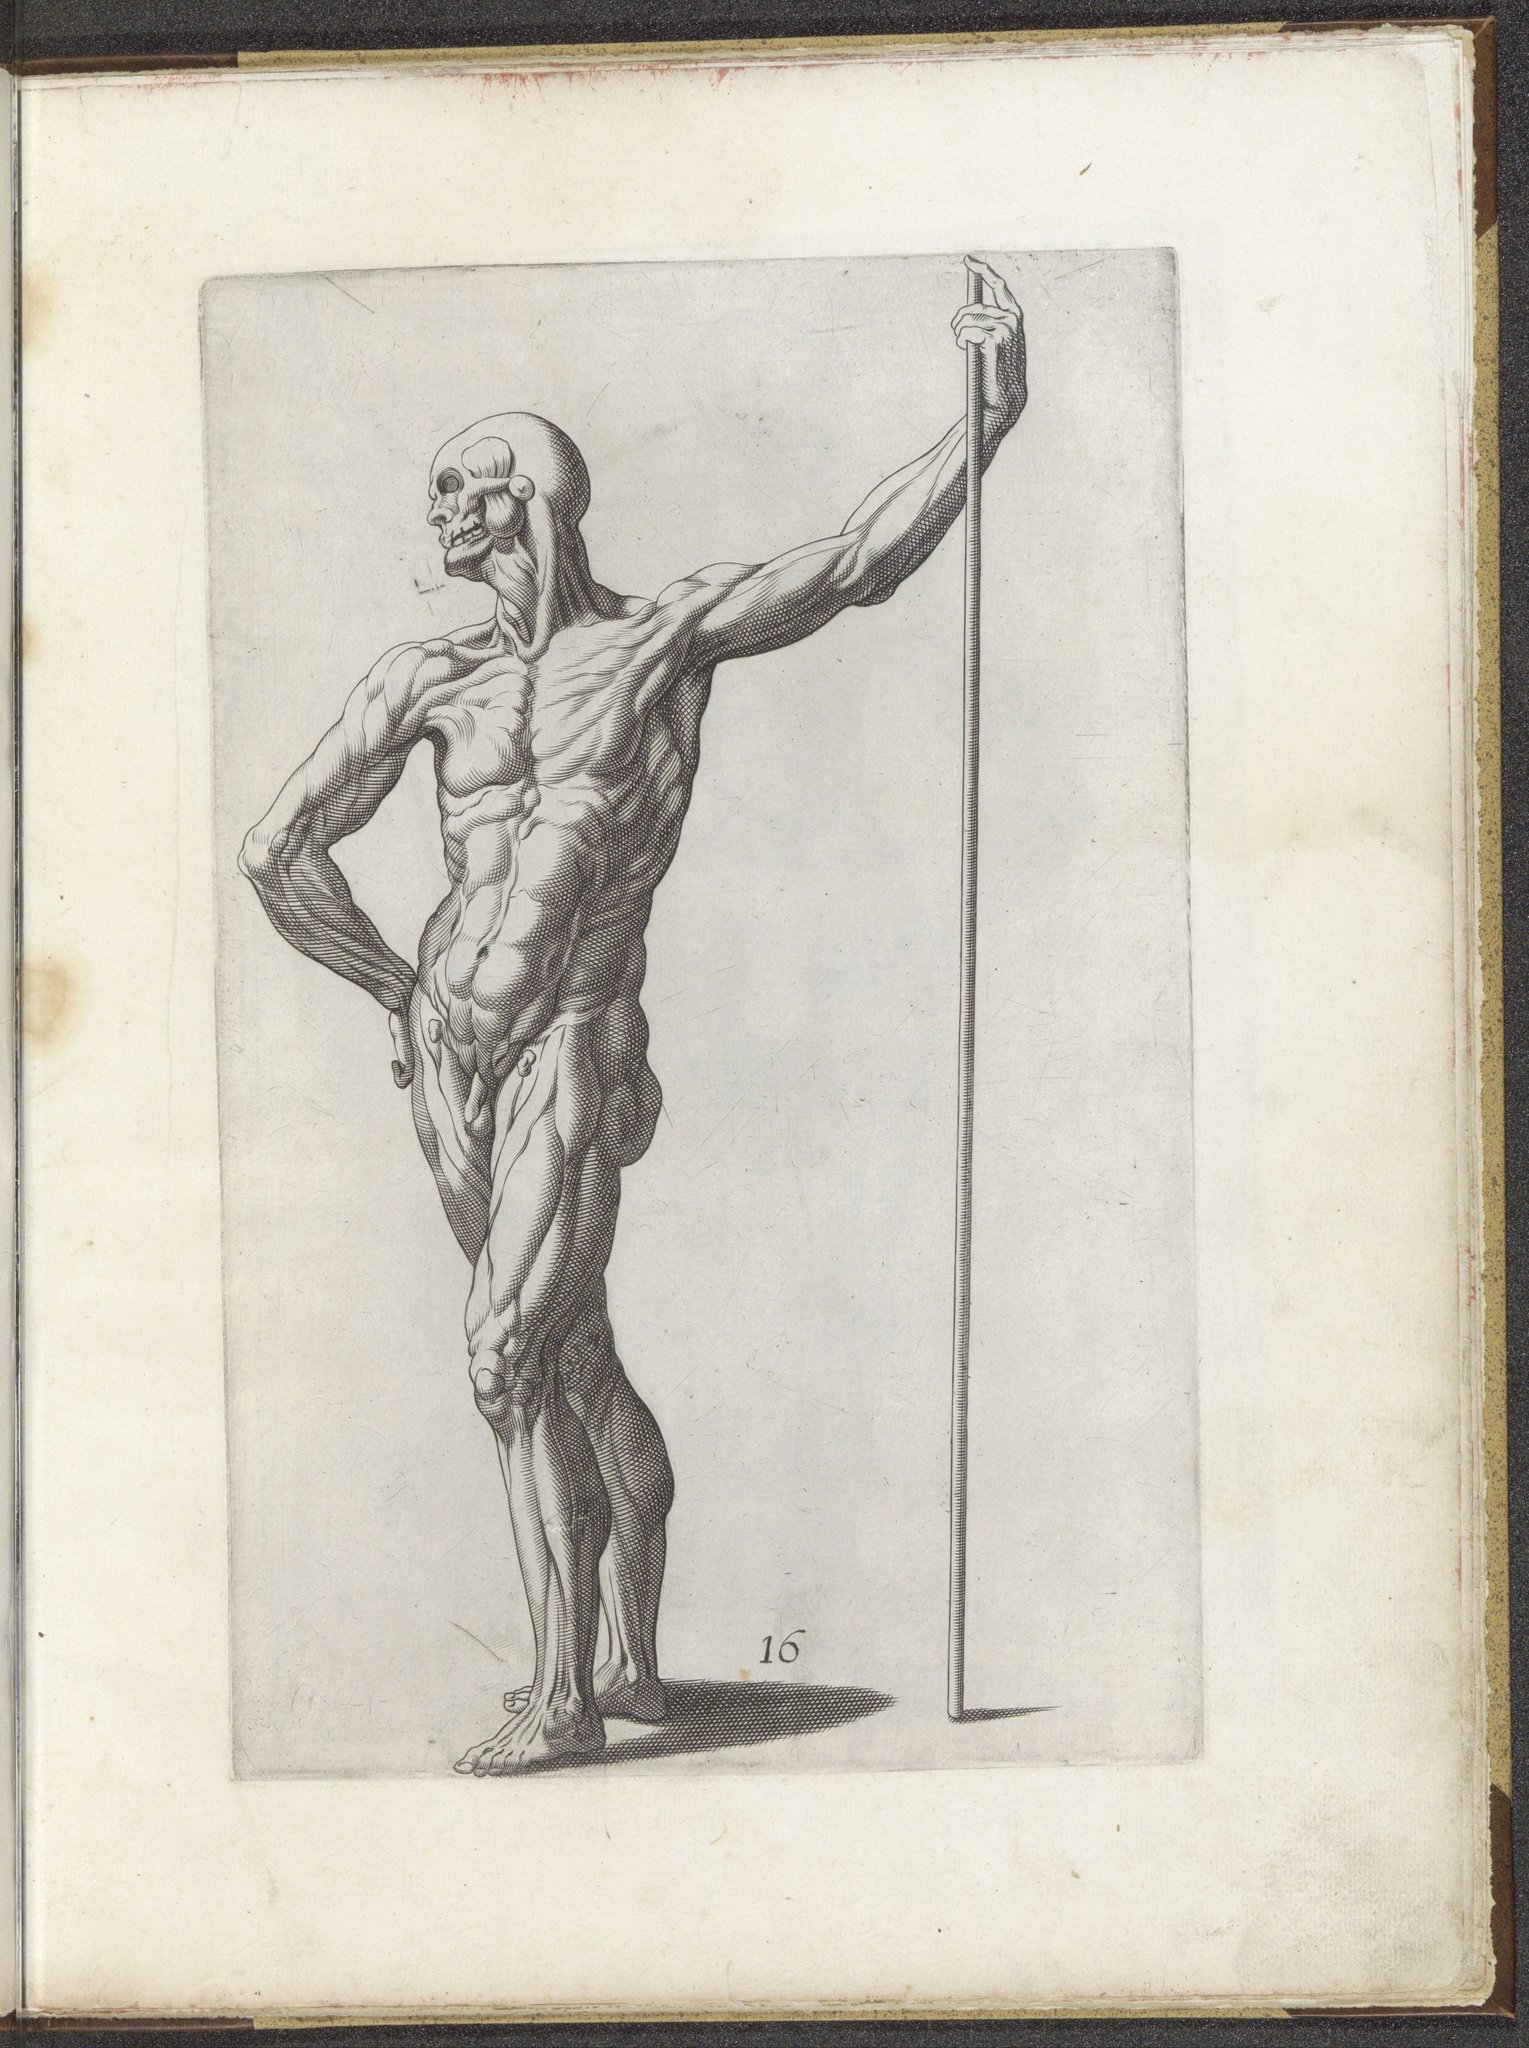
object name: album leaf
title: Tekenvoorbeeld van een staand écorché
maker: pieter de jode (i)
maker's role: draughtsman, print maker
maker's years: 1570-1634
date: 1629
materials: paper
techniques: engraving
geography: antwerp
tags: anatomical model of the muscles, muscle-man, 'écorché'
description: Tekenvoorbeeld van een staand écorché, een gevilde man, met een stok in de linkerhand. Deze prent maakt deel uit van een album.